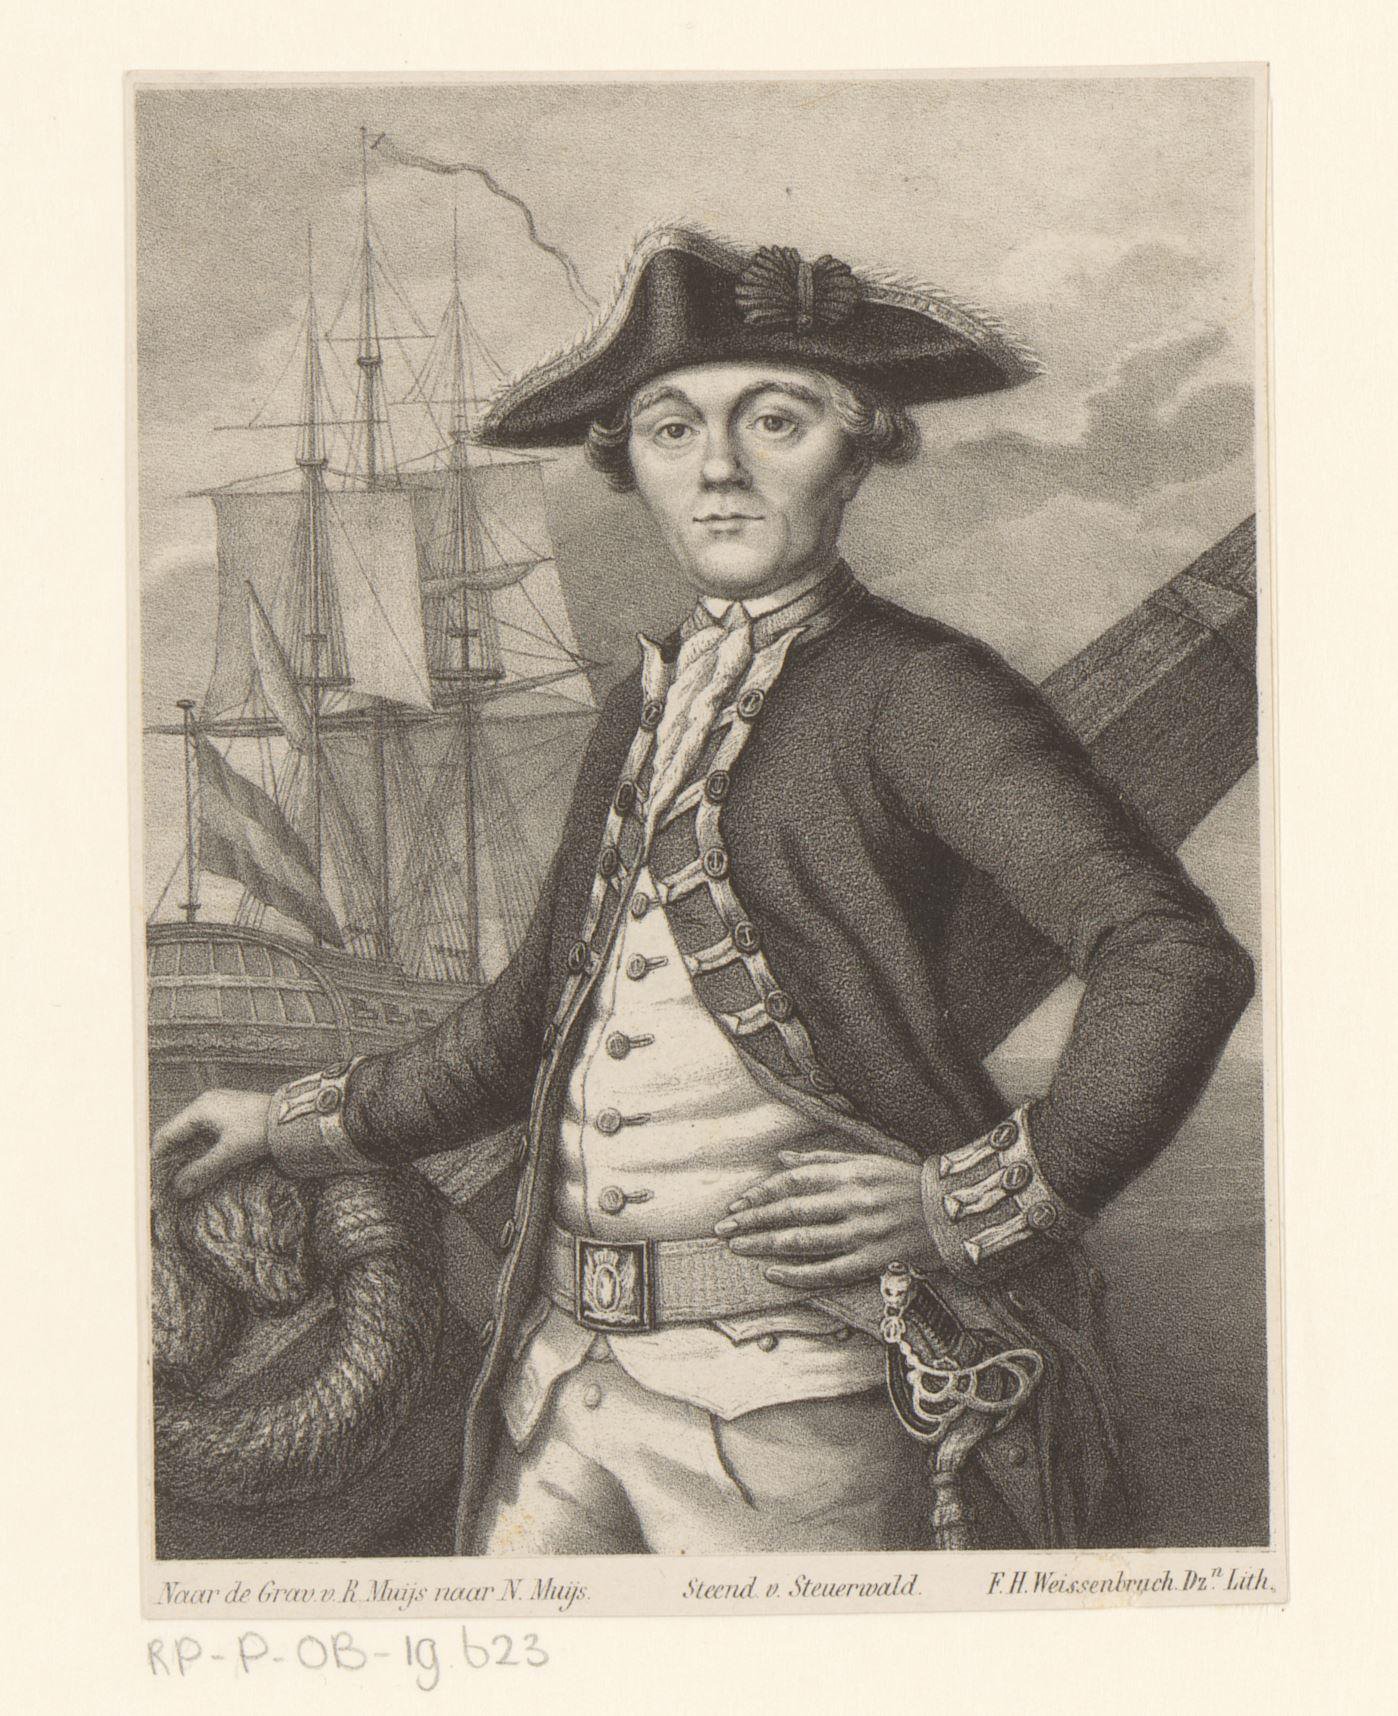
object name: print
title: Portret van Gerardus Oorthuys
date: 1858-1862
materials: paper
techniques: lithograph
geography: the hague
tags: rotterdam, gerardus oorthuys, historical persons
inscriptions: collector's mark: Lugt 2228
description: Prent uit: Jonge, J.C. de. Geschiedenis van het Nederlandsche zeewezen. Haarlem: Jonge, J.K.J. de, 1858-62.